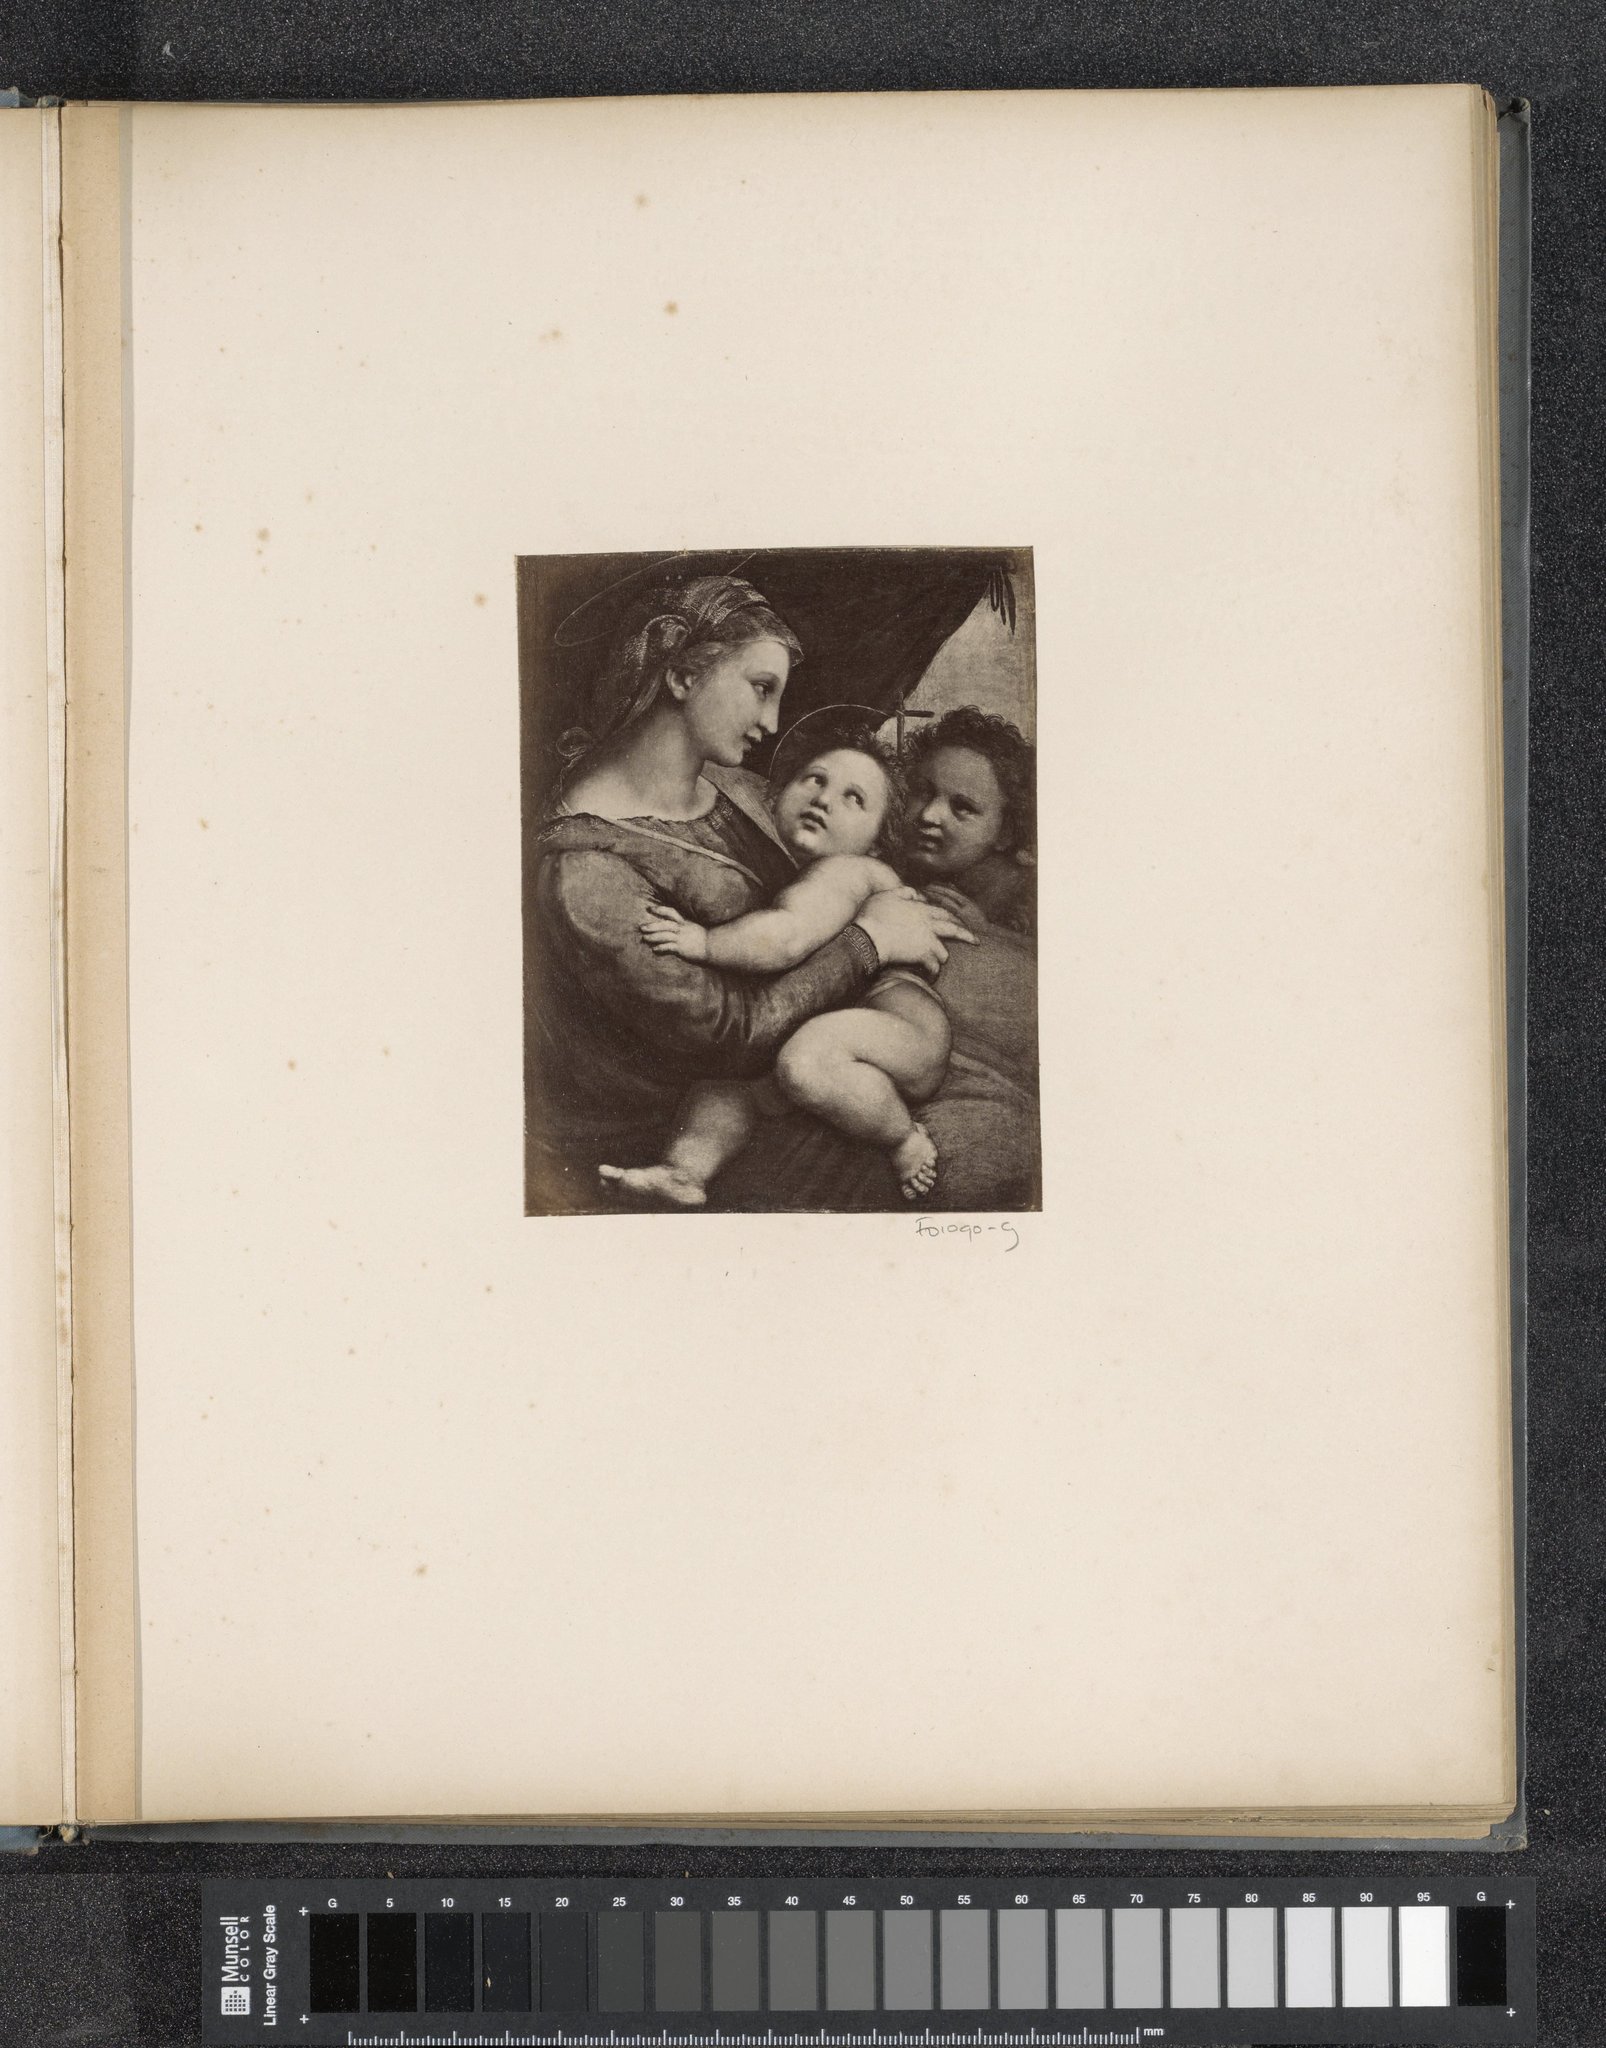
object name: reproduction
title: Fotoreproductie van (vermoedelijk) een prent naar een schilderij door Rafael, voorstellend Maria met Kind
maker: Anonymous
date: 1870-1900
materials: paper, photographic support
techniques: albumen print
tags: madonna: i.e. mary with the christ-child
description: Onderdeel van Reisalbum met foto's van bezienswaardigheden in Duitsland en Oostenrijk en van kunstwerken.